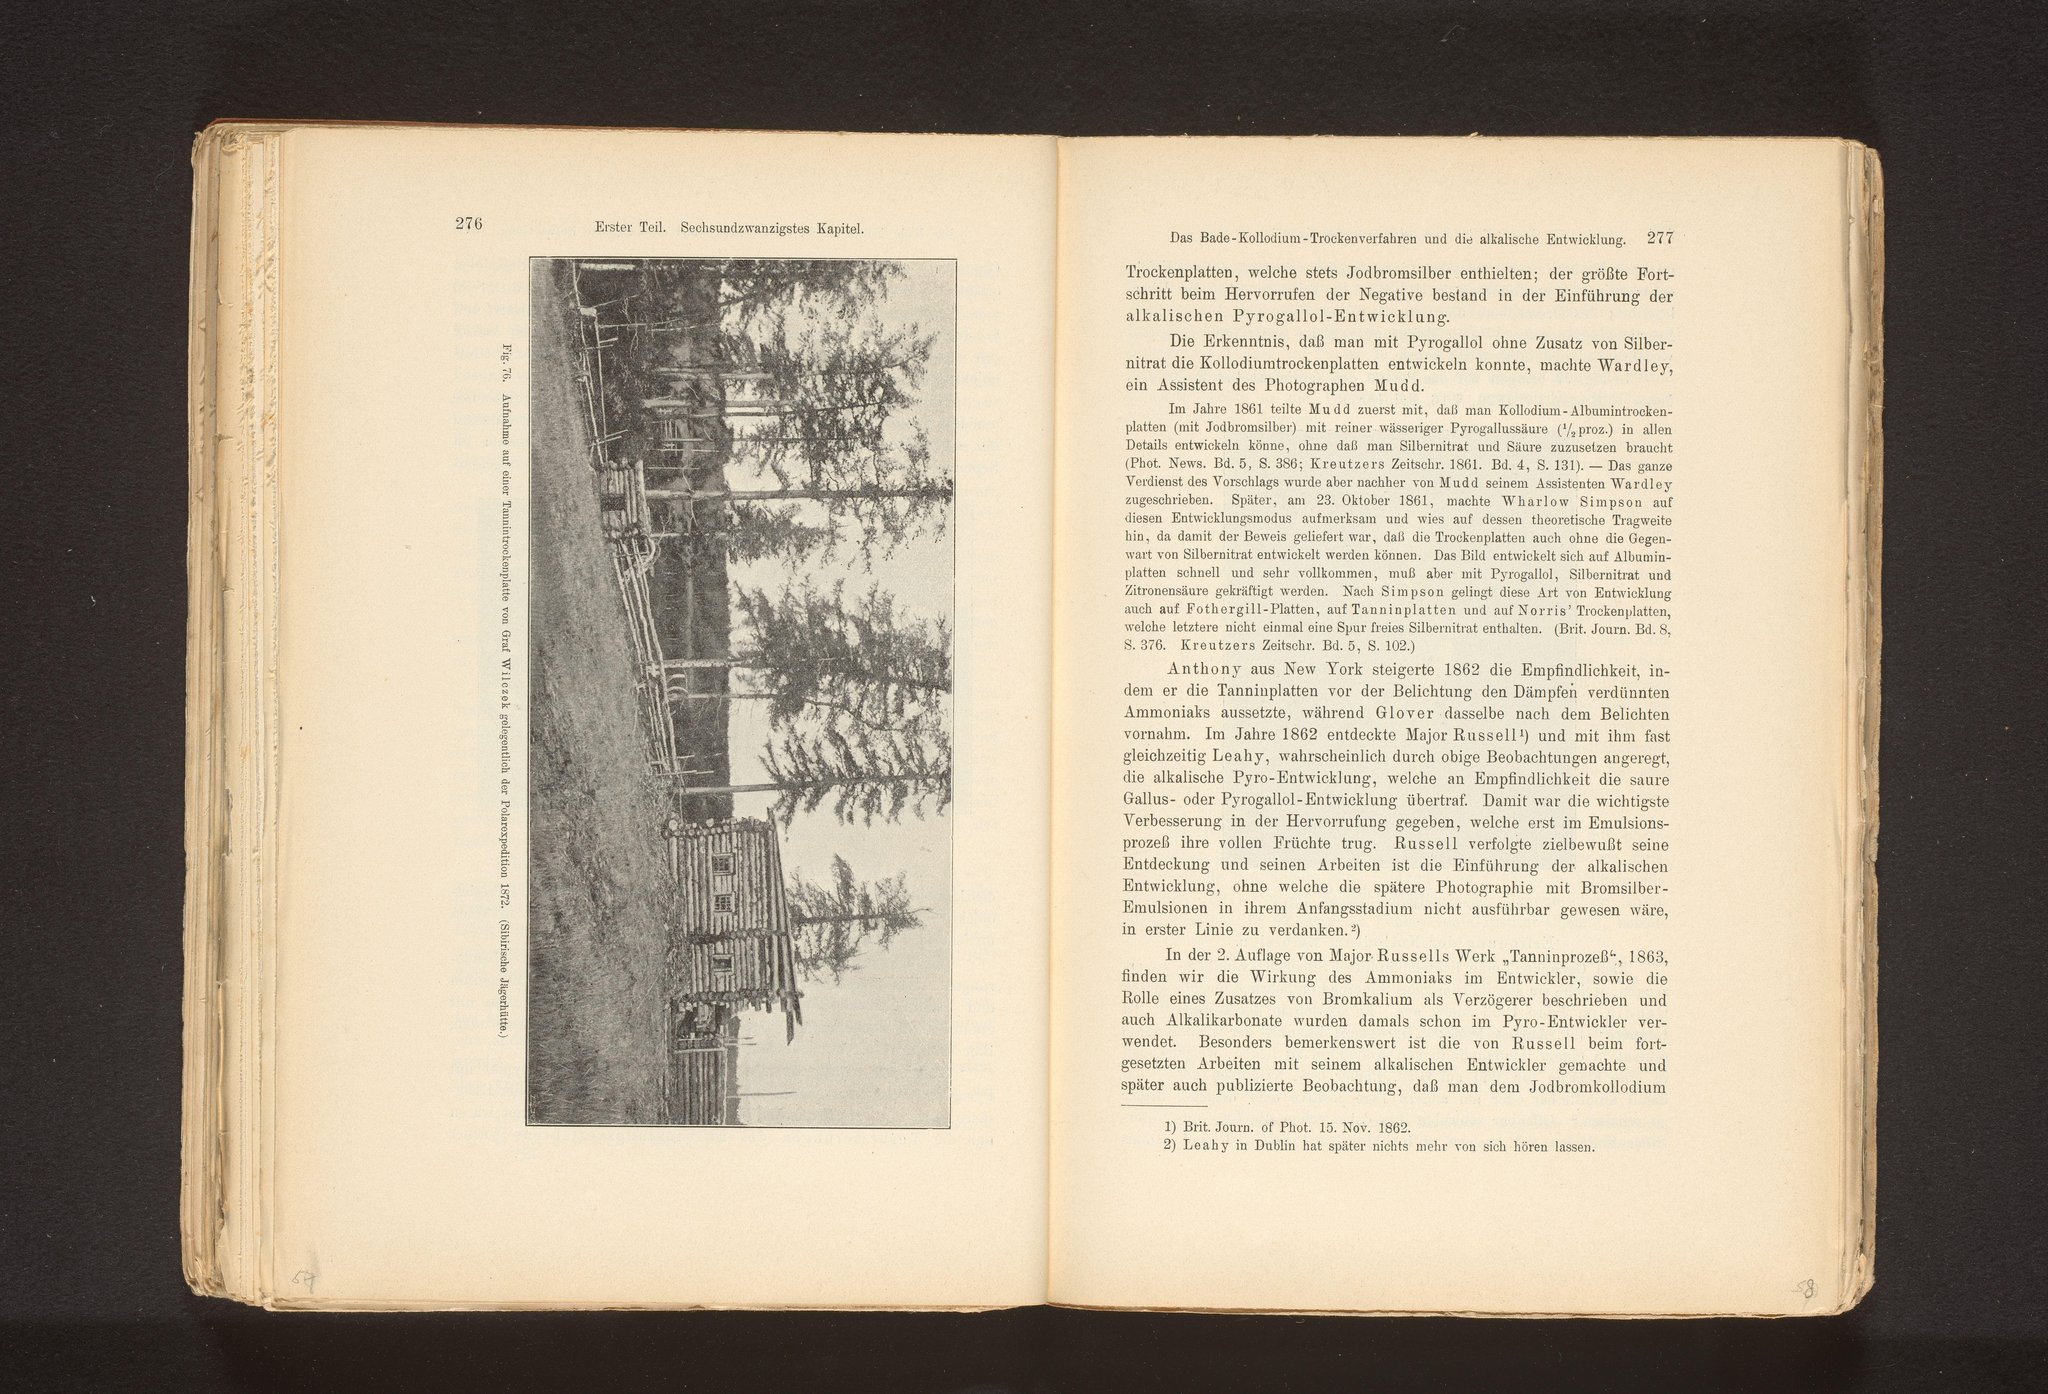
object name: photomechanical print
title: Sibirische Jägerhütte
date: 1900-1905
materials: paper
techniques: autotype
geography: siberia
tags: log-cabin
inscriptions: number: ‘Fig. 76.’, inscription: ‘Aufnahme (...) 1872.’